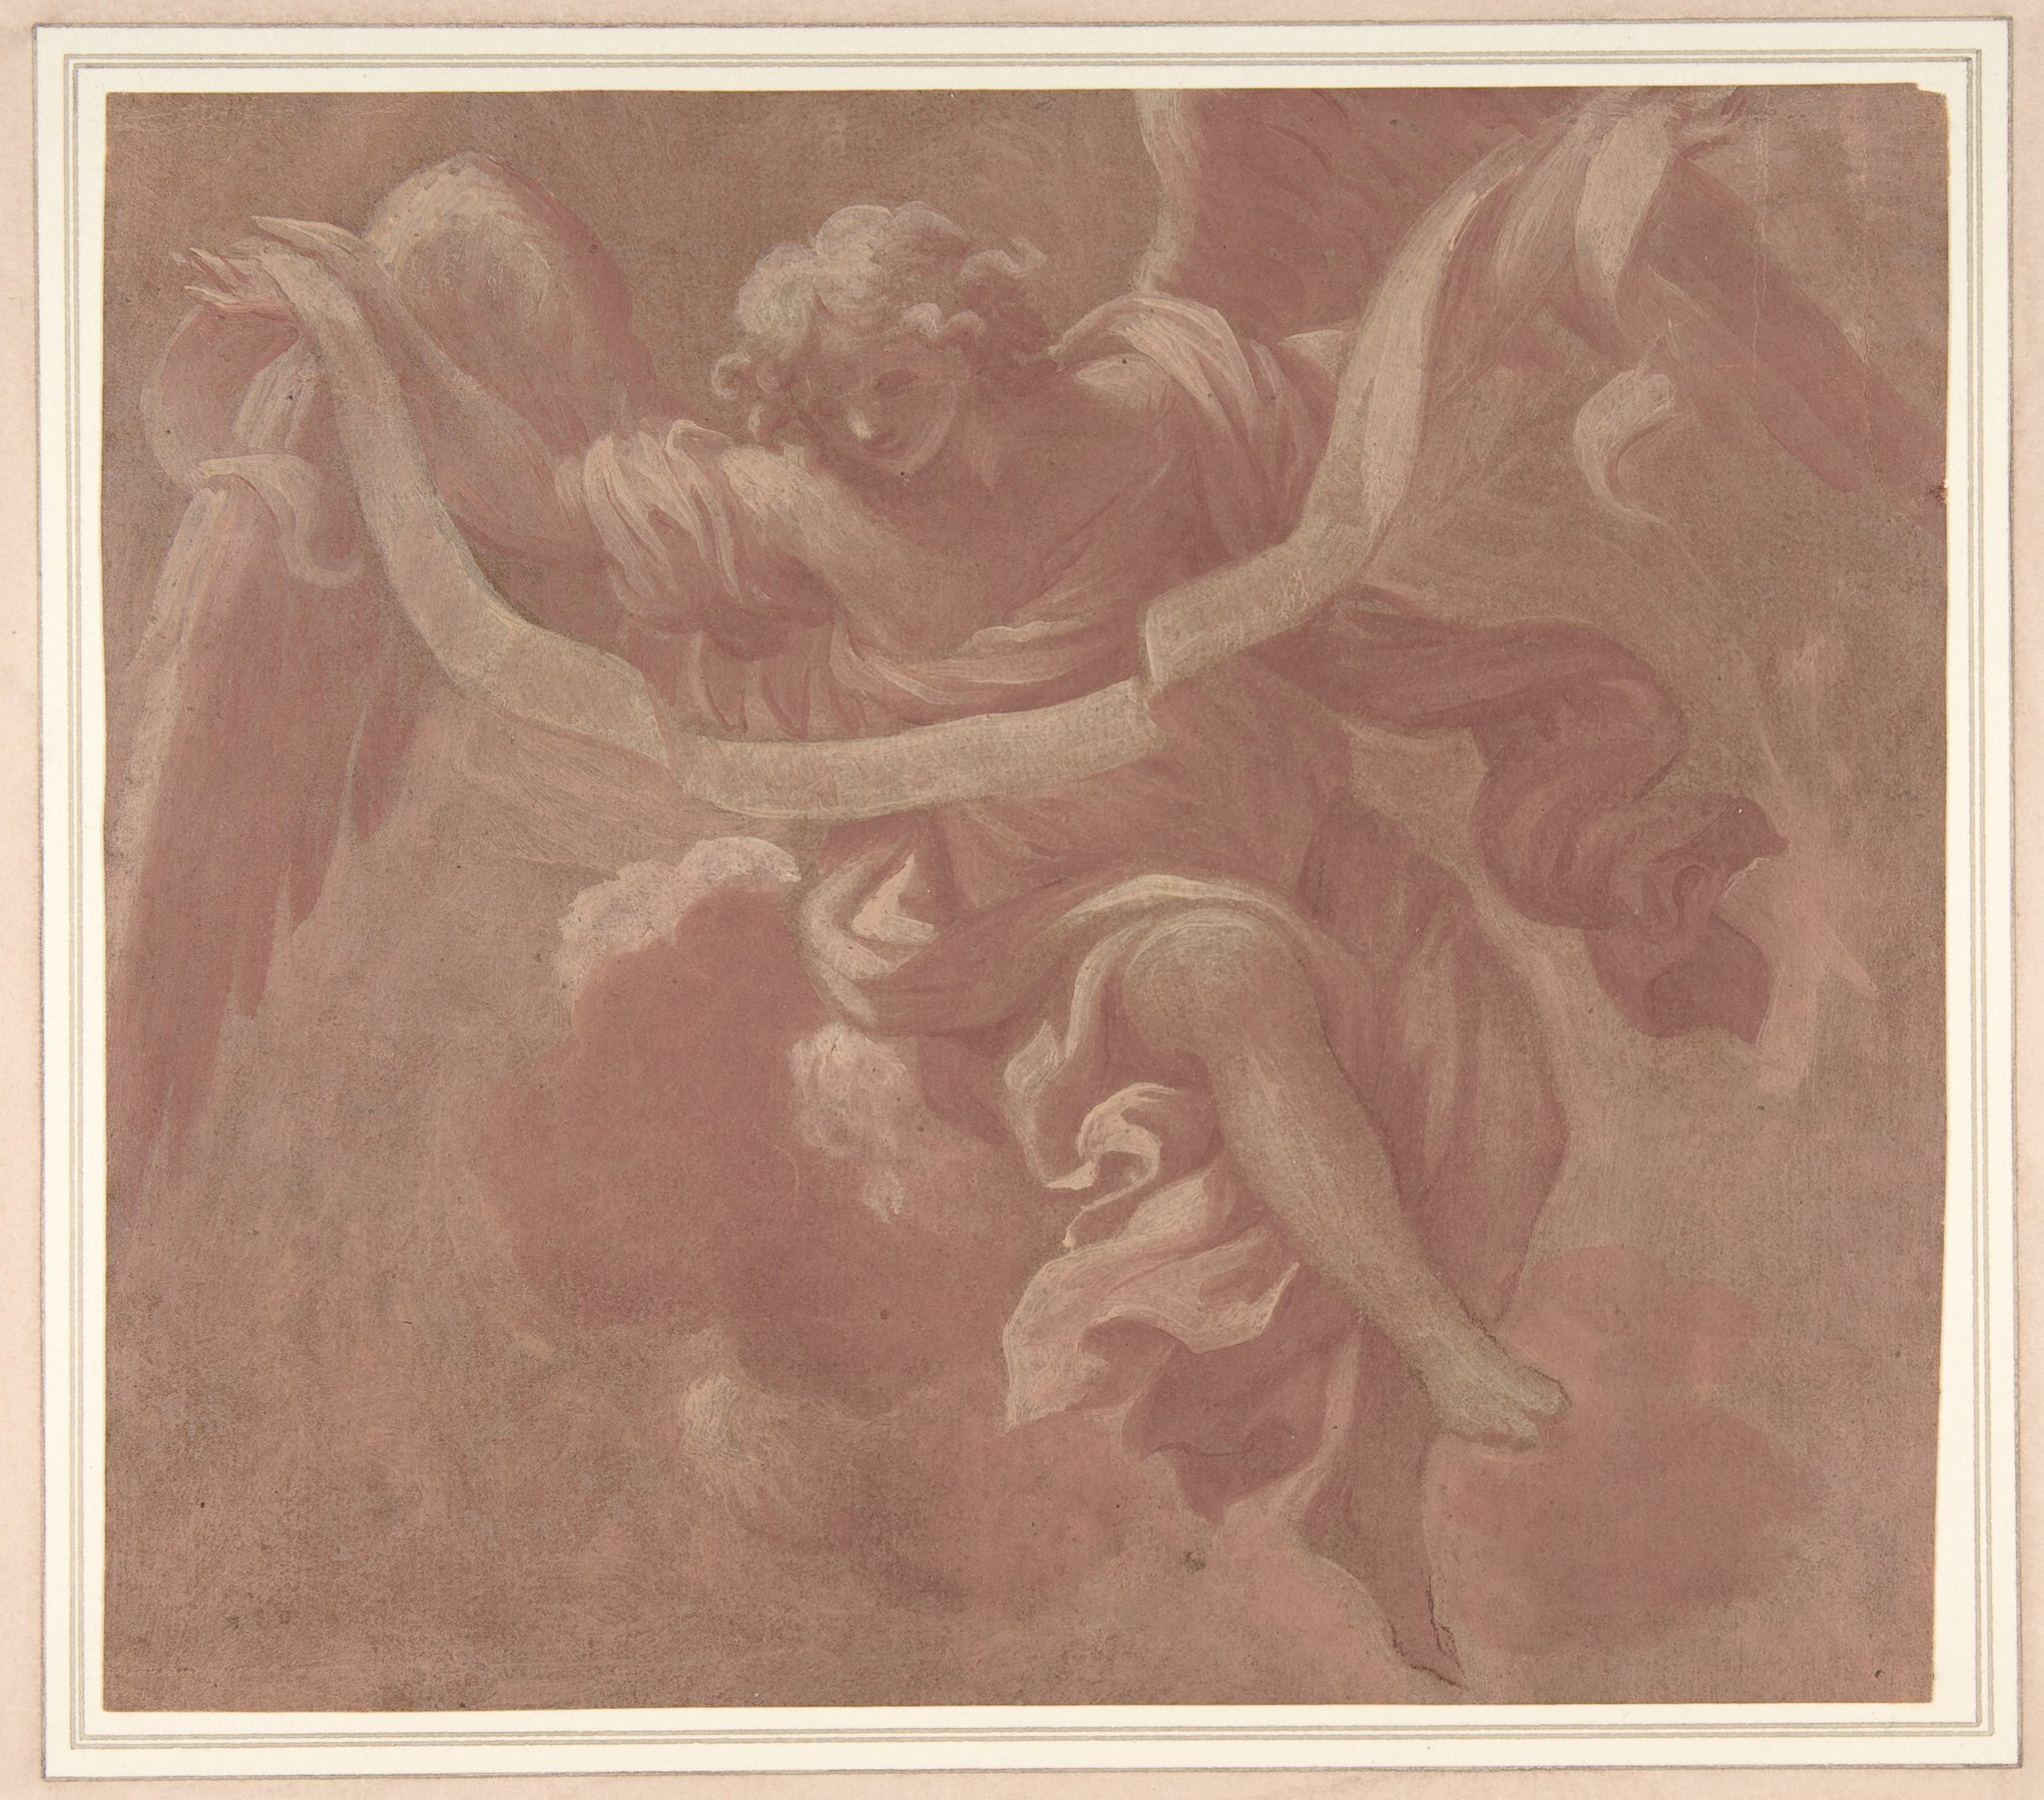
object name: drawing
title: Angel Holding a Banderole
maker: antonio franchi (il lucchese)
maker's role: artist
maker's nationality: italian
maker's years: 1638-1709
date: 1706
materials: chalk, paper, paint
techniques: brush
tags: angels